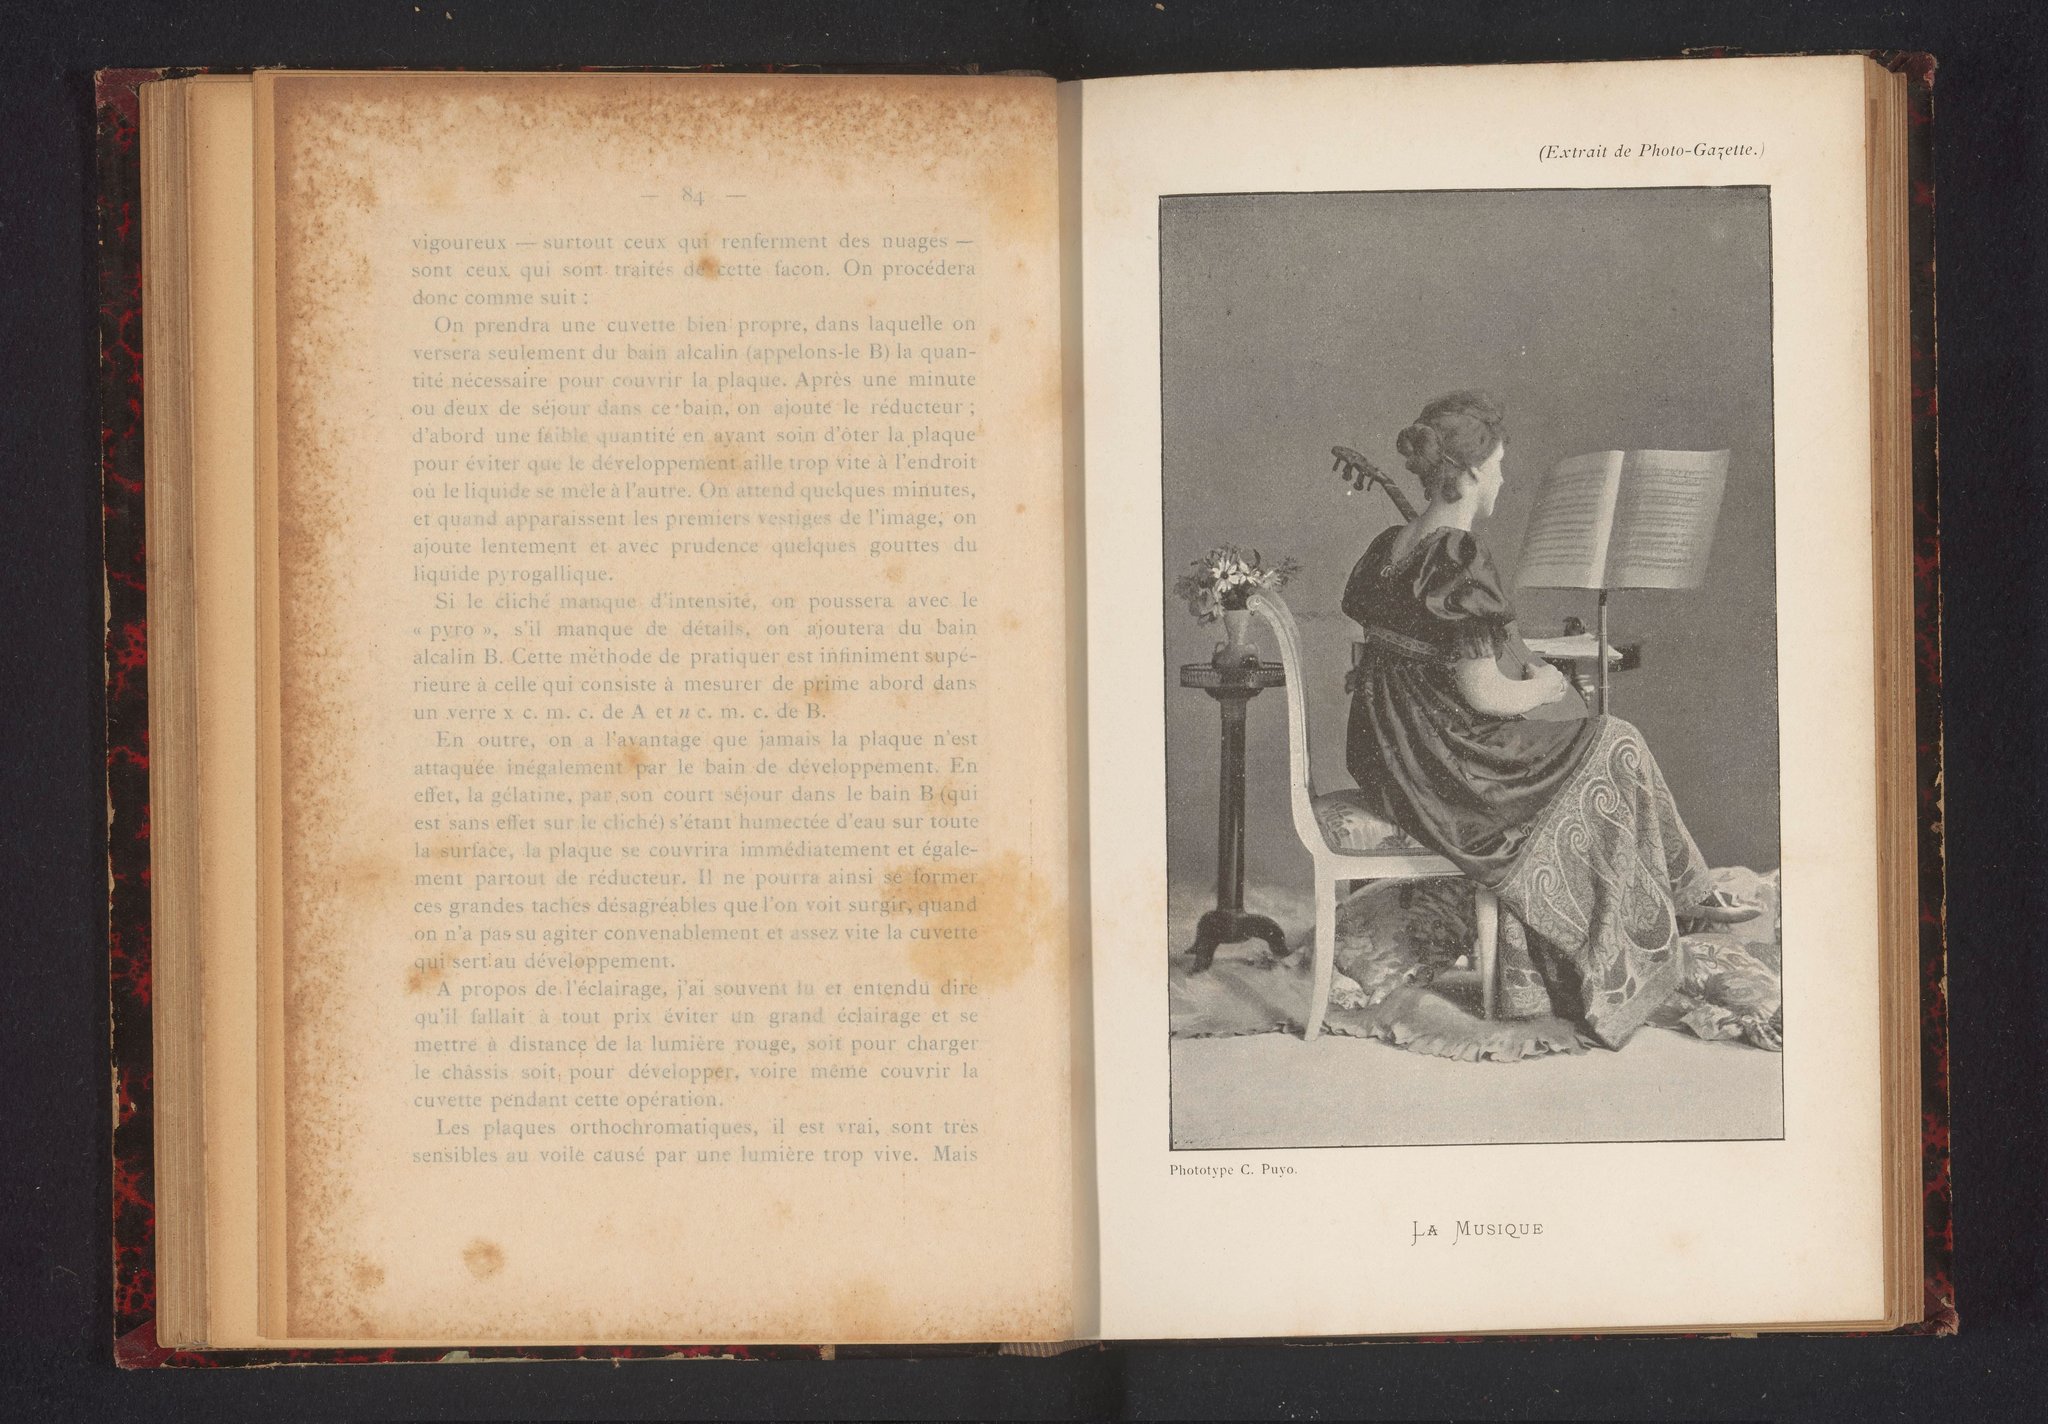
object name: page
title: La Musique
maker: constant puyo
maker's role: fotograaf, schrijver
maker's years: 1857-1933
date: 1892-1897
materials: paper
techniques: autotype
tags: cithern, mandolin, guitar, balalaika (+ artist at work), historical persons not known by name - bb - woman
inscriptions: inscription: ‘(Extrait de Photo-Gazette.)’